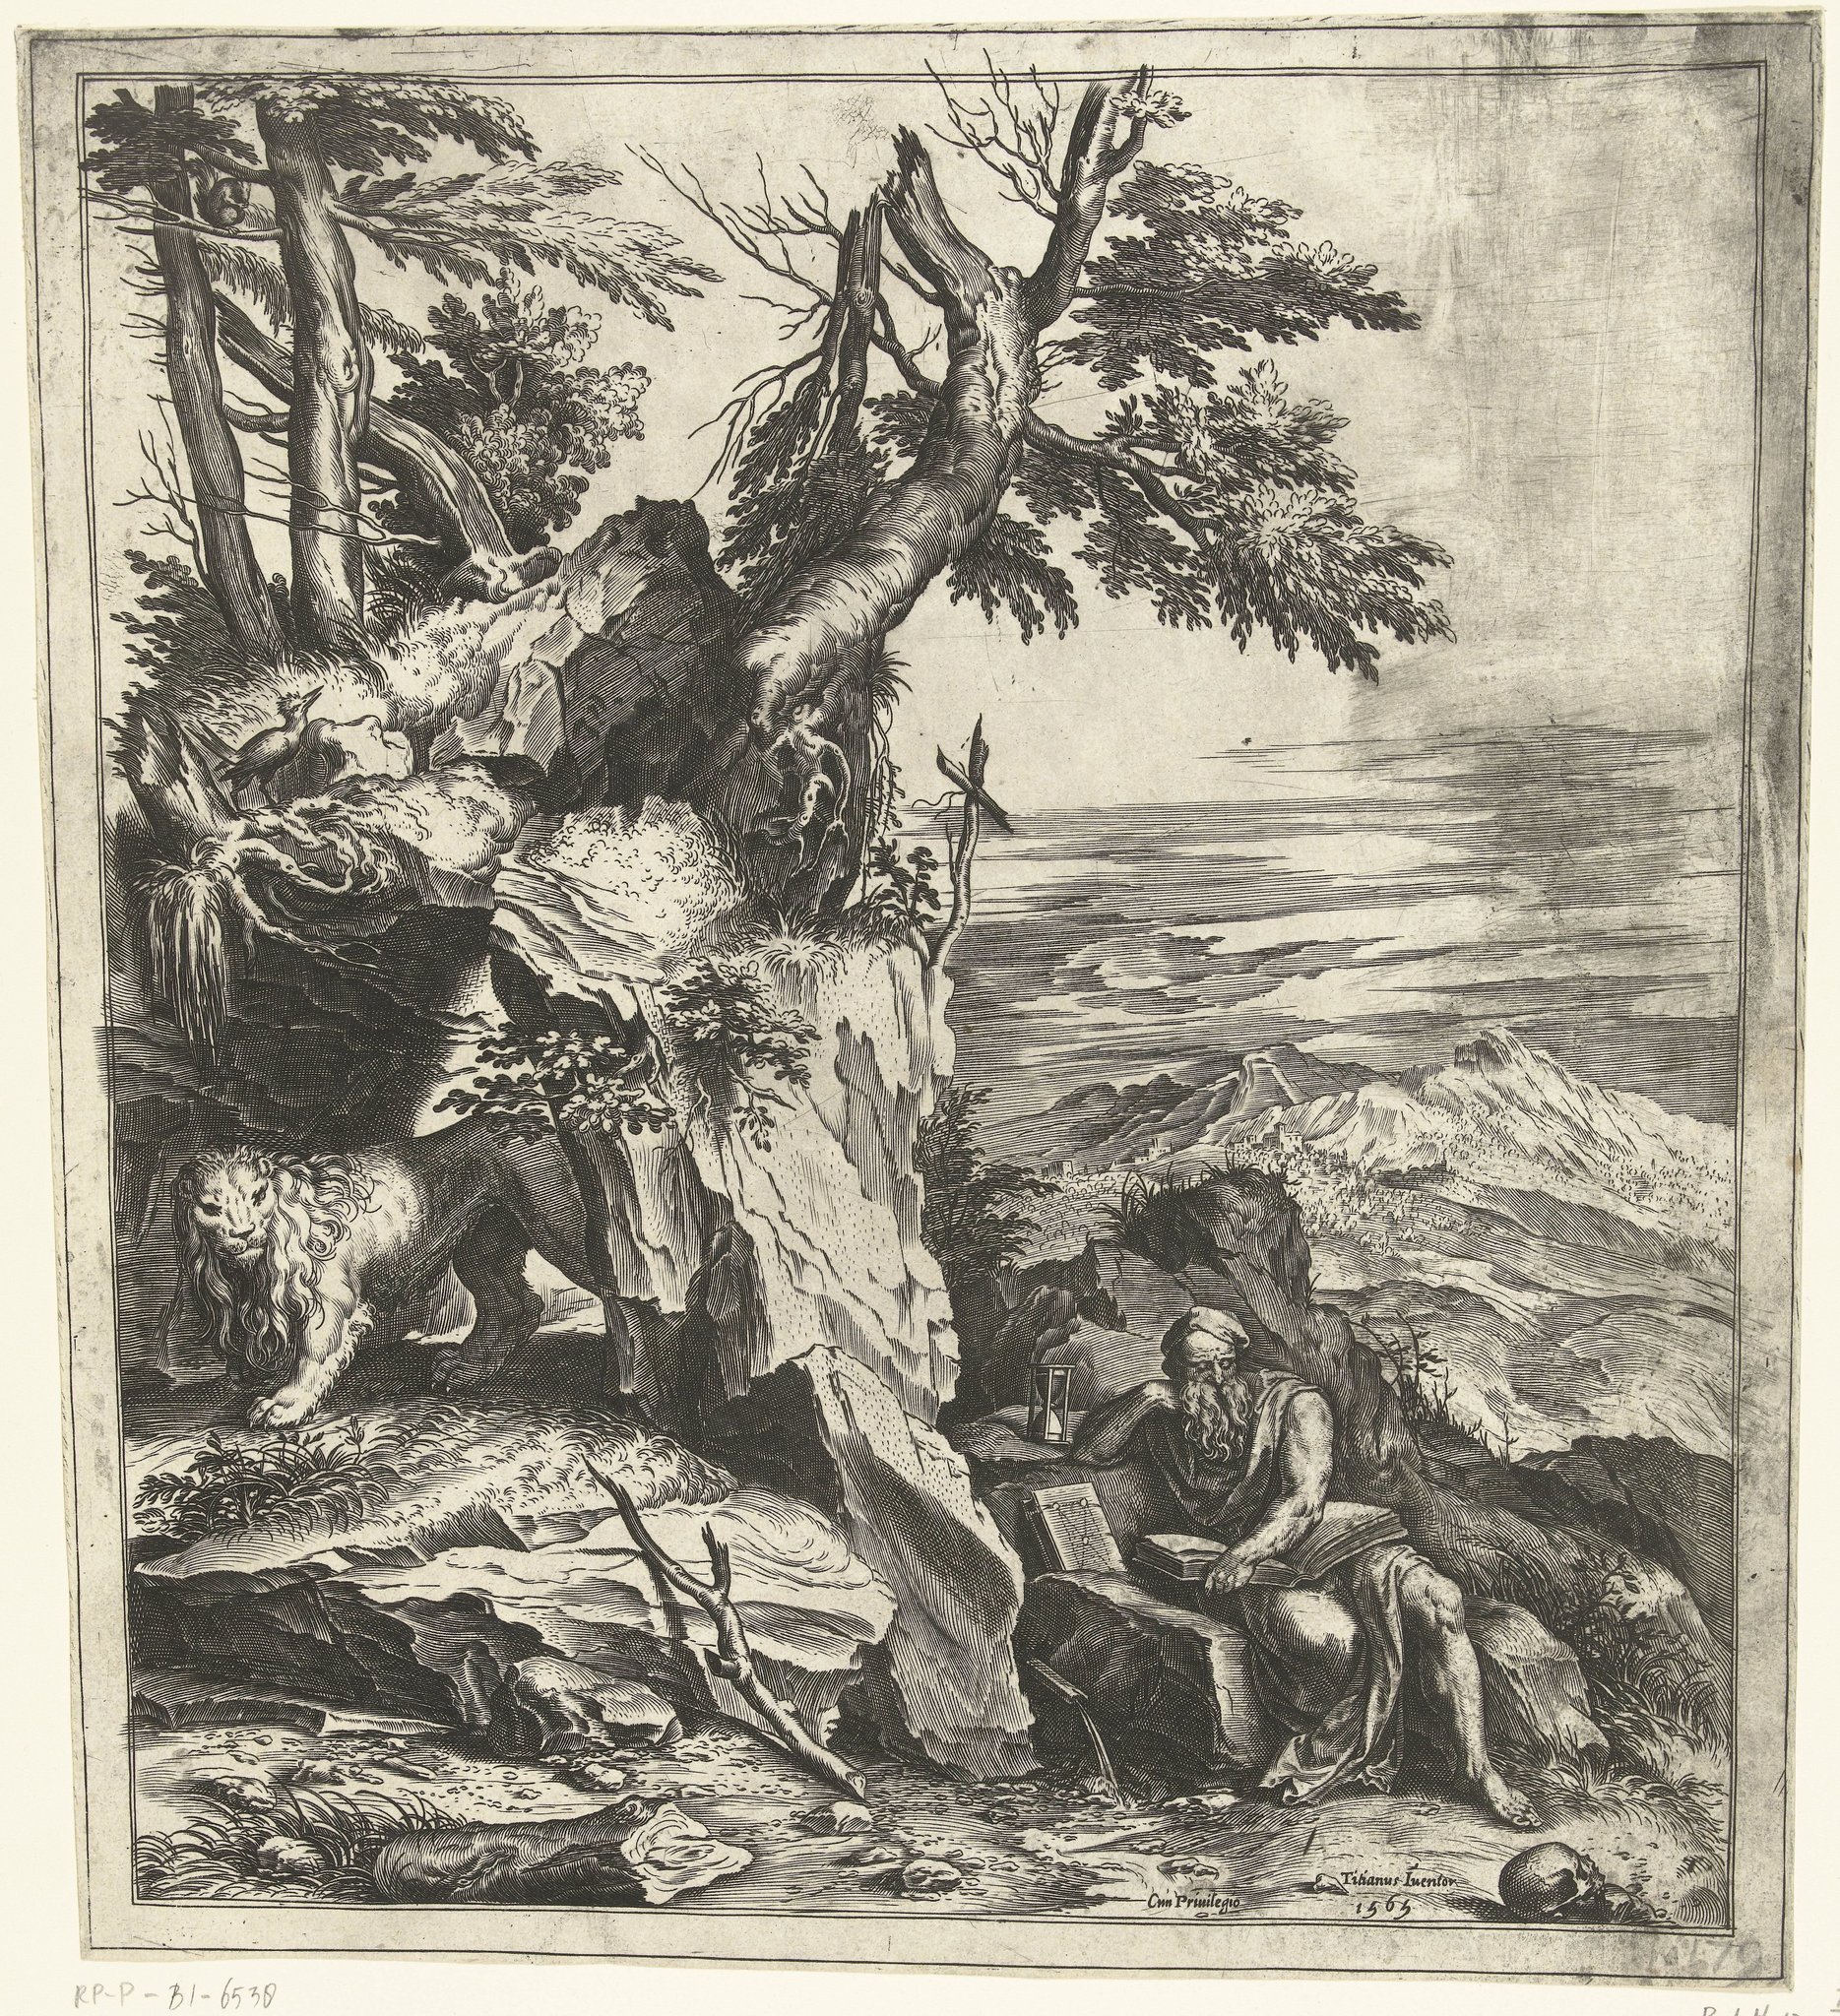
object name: print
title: Landschap met lezende Hieronymus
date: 1565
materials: paper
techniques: engraving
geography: rome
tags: the monk and hermit jerome (hieronymus); possible attributes: book, cardinal's hat, crucifix, hour-glass, lion, skull, stone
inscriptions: collector's mark: Lugt 240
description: De heilige Hieronymus zit in een bergachtig landschap op een rots te lezen. Naast hem een boek en een zandloper. De leeuw, zijn attribuut, struint tussen de rotsen.